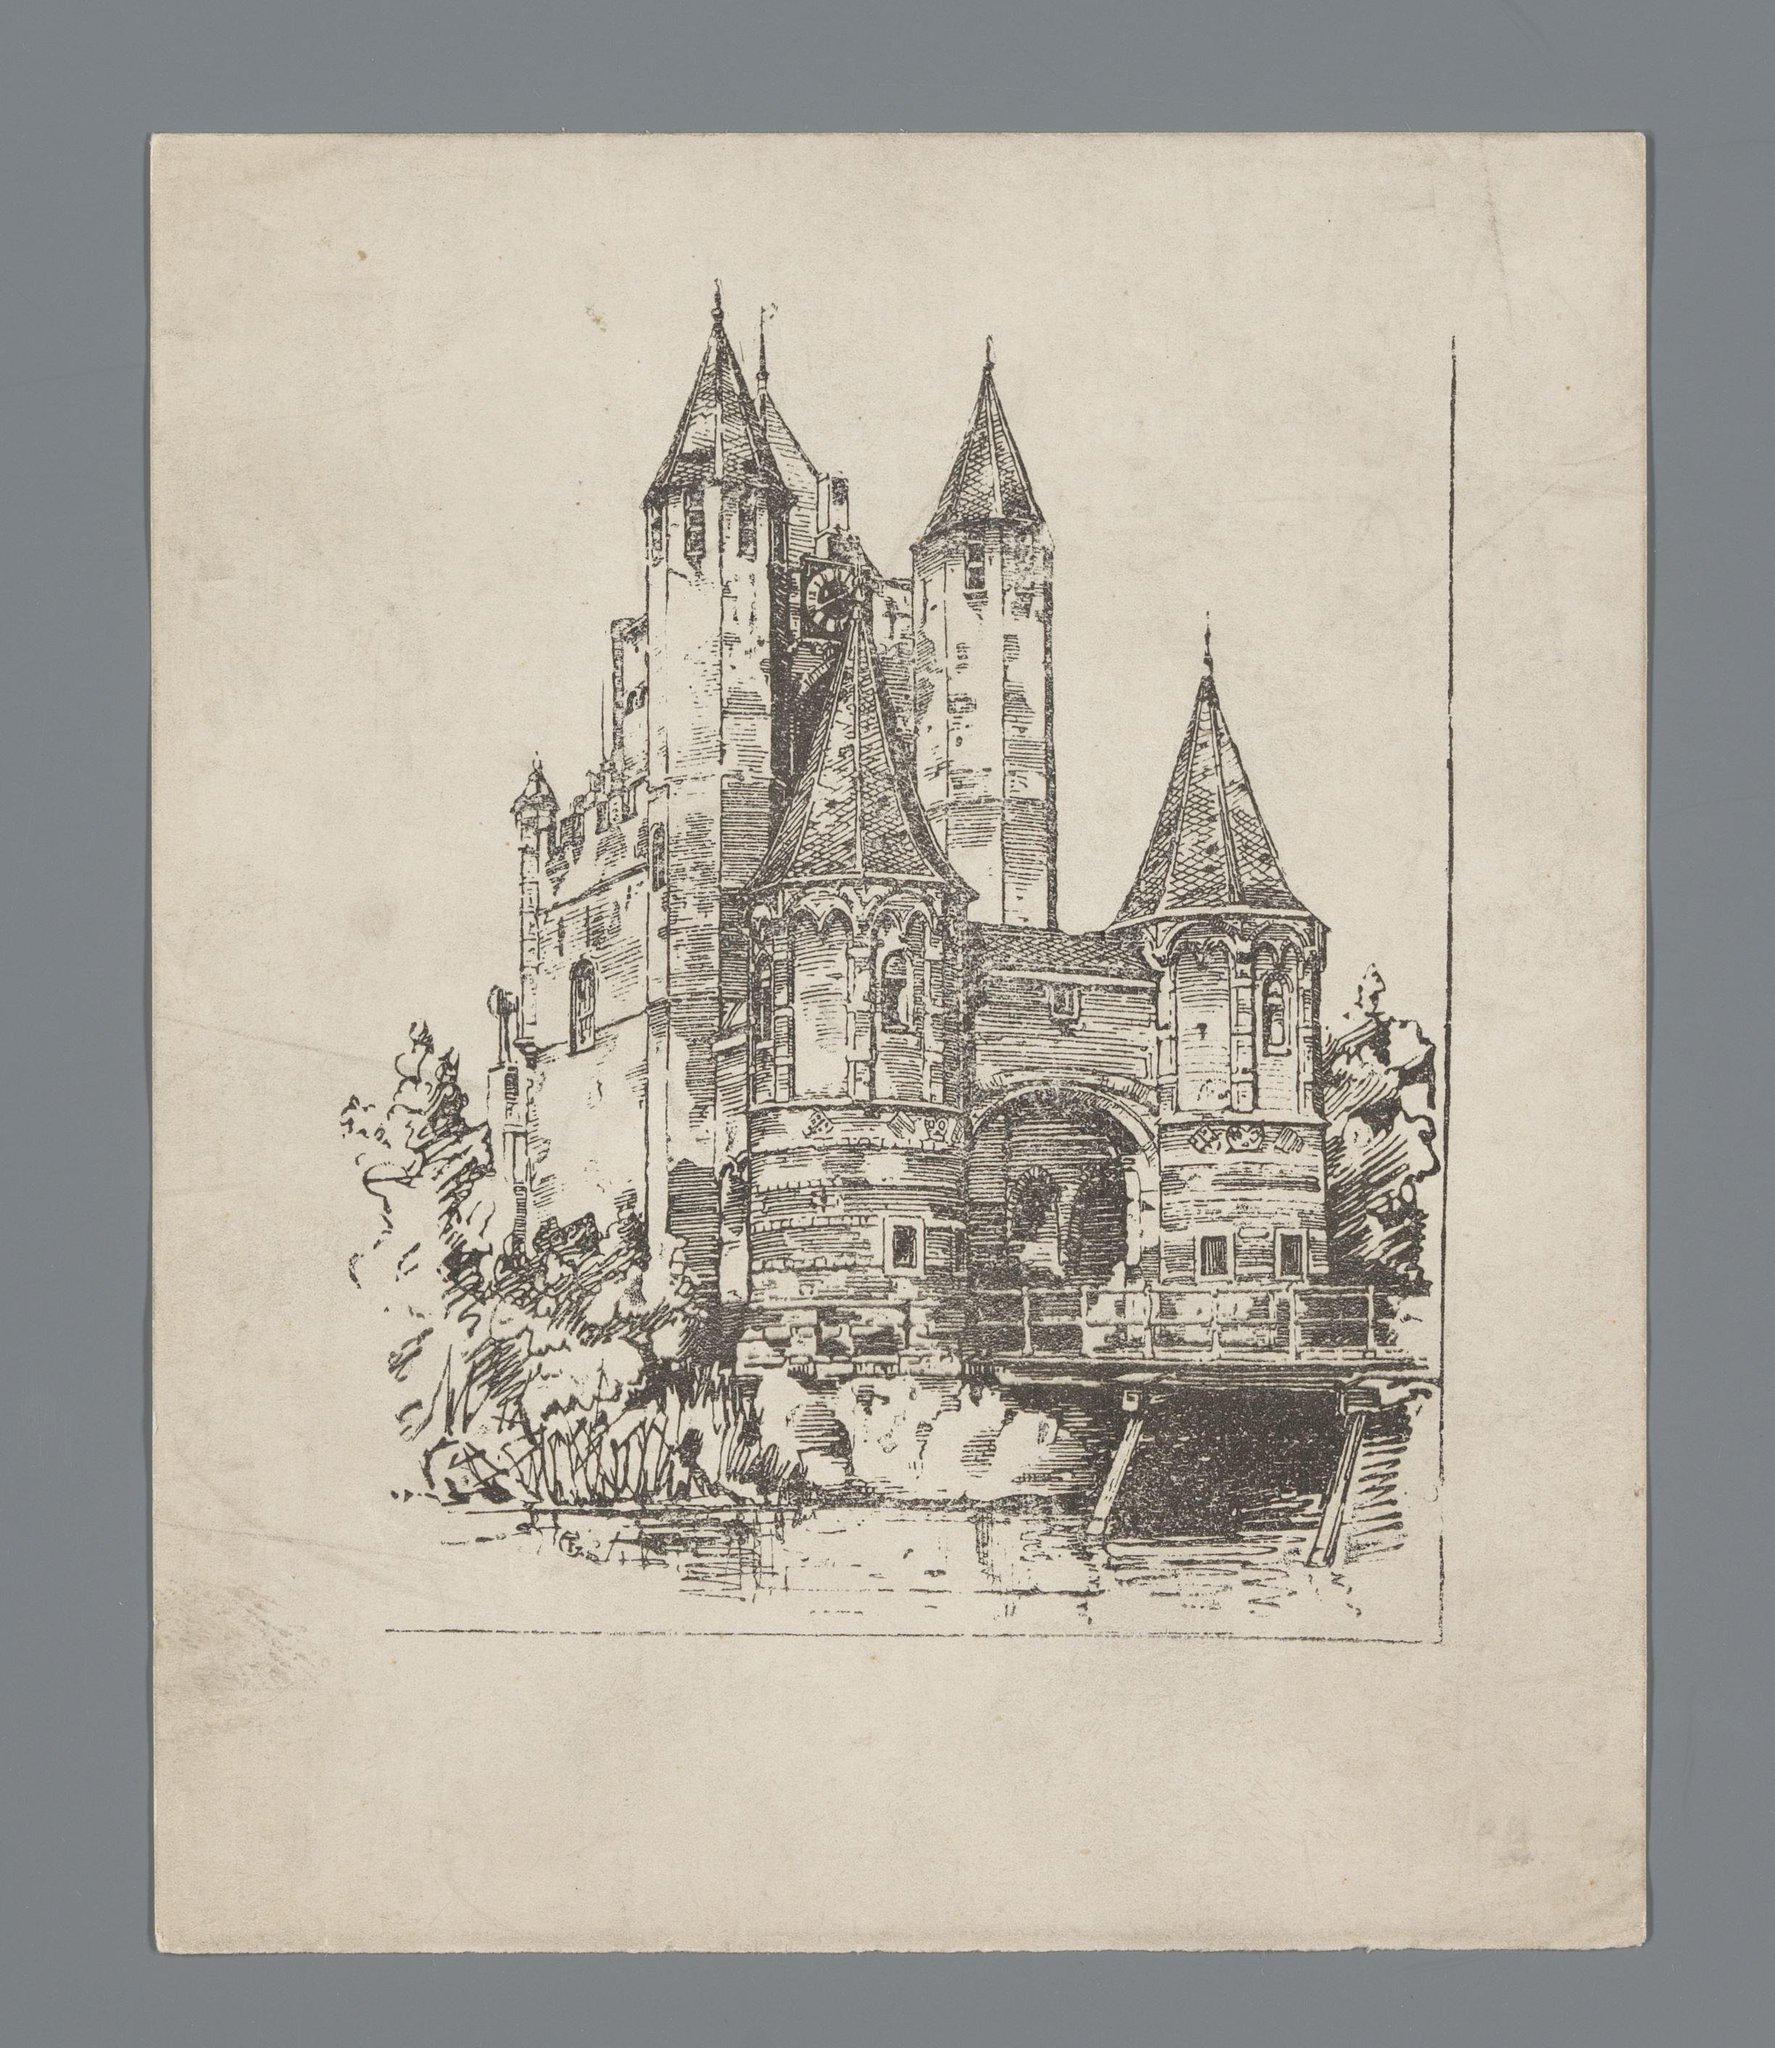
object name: print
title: Gezicht op de Amsterdamse Poort in Haarlem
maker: Anonymous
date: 1800-1899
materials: paper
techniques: lithograph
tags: city-gate